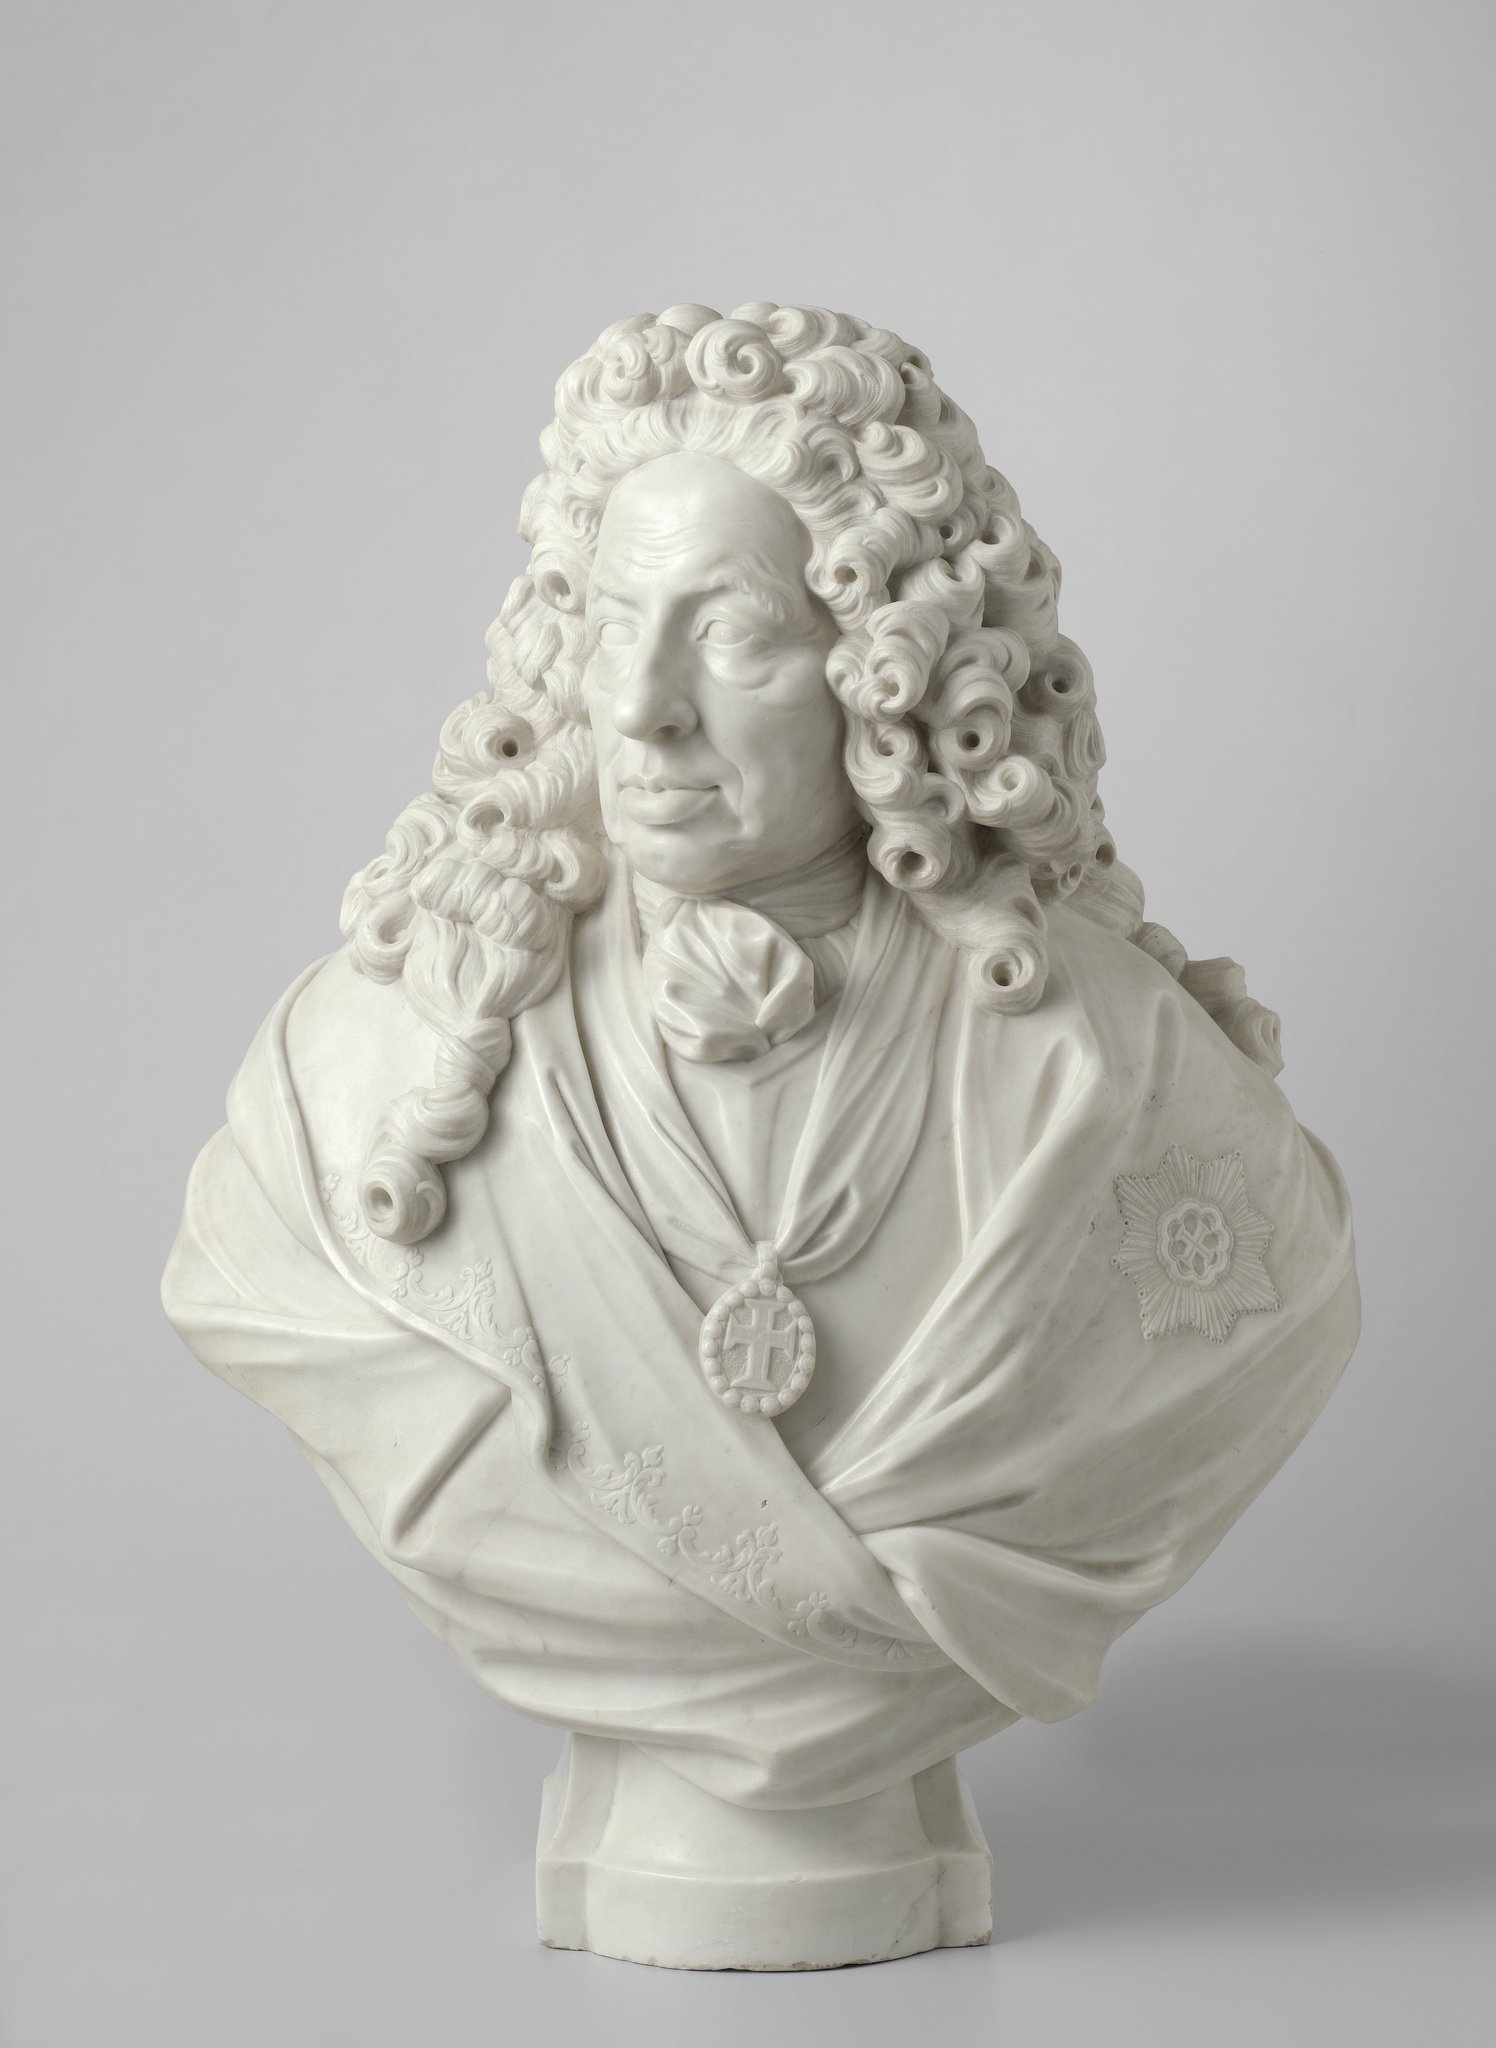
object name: bust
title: Bust of Dom Luis da Cunha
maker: jan baptist xavery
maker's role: sculptor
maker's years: 1697-1742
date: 1737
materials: marble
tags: historical persons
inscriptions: signature and date: ‘J:B:XAVERY.F: // 1737’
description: Da Cunha was the Portuguese ambassador in The Hague from 1728 to 1736. He then left for Paris, where he had previously served as well. This bust was completed only after Da Cunha’s departure from The Hague. As an expert on contemporary French art, Da Cunha was probably the most influential of Prince William IV’s artistic advisors.